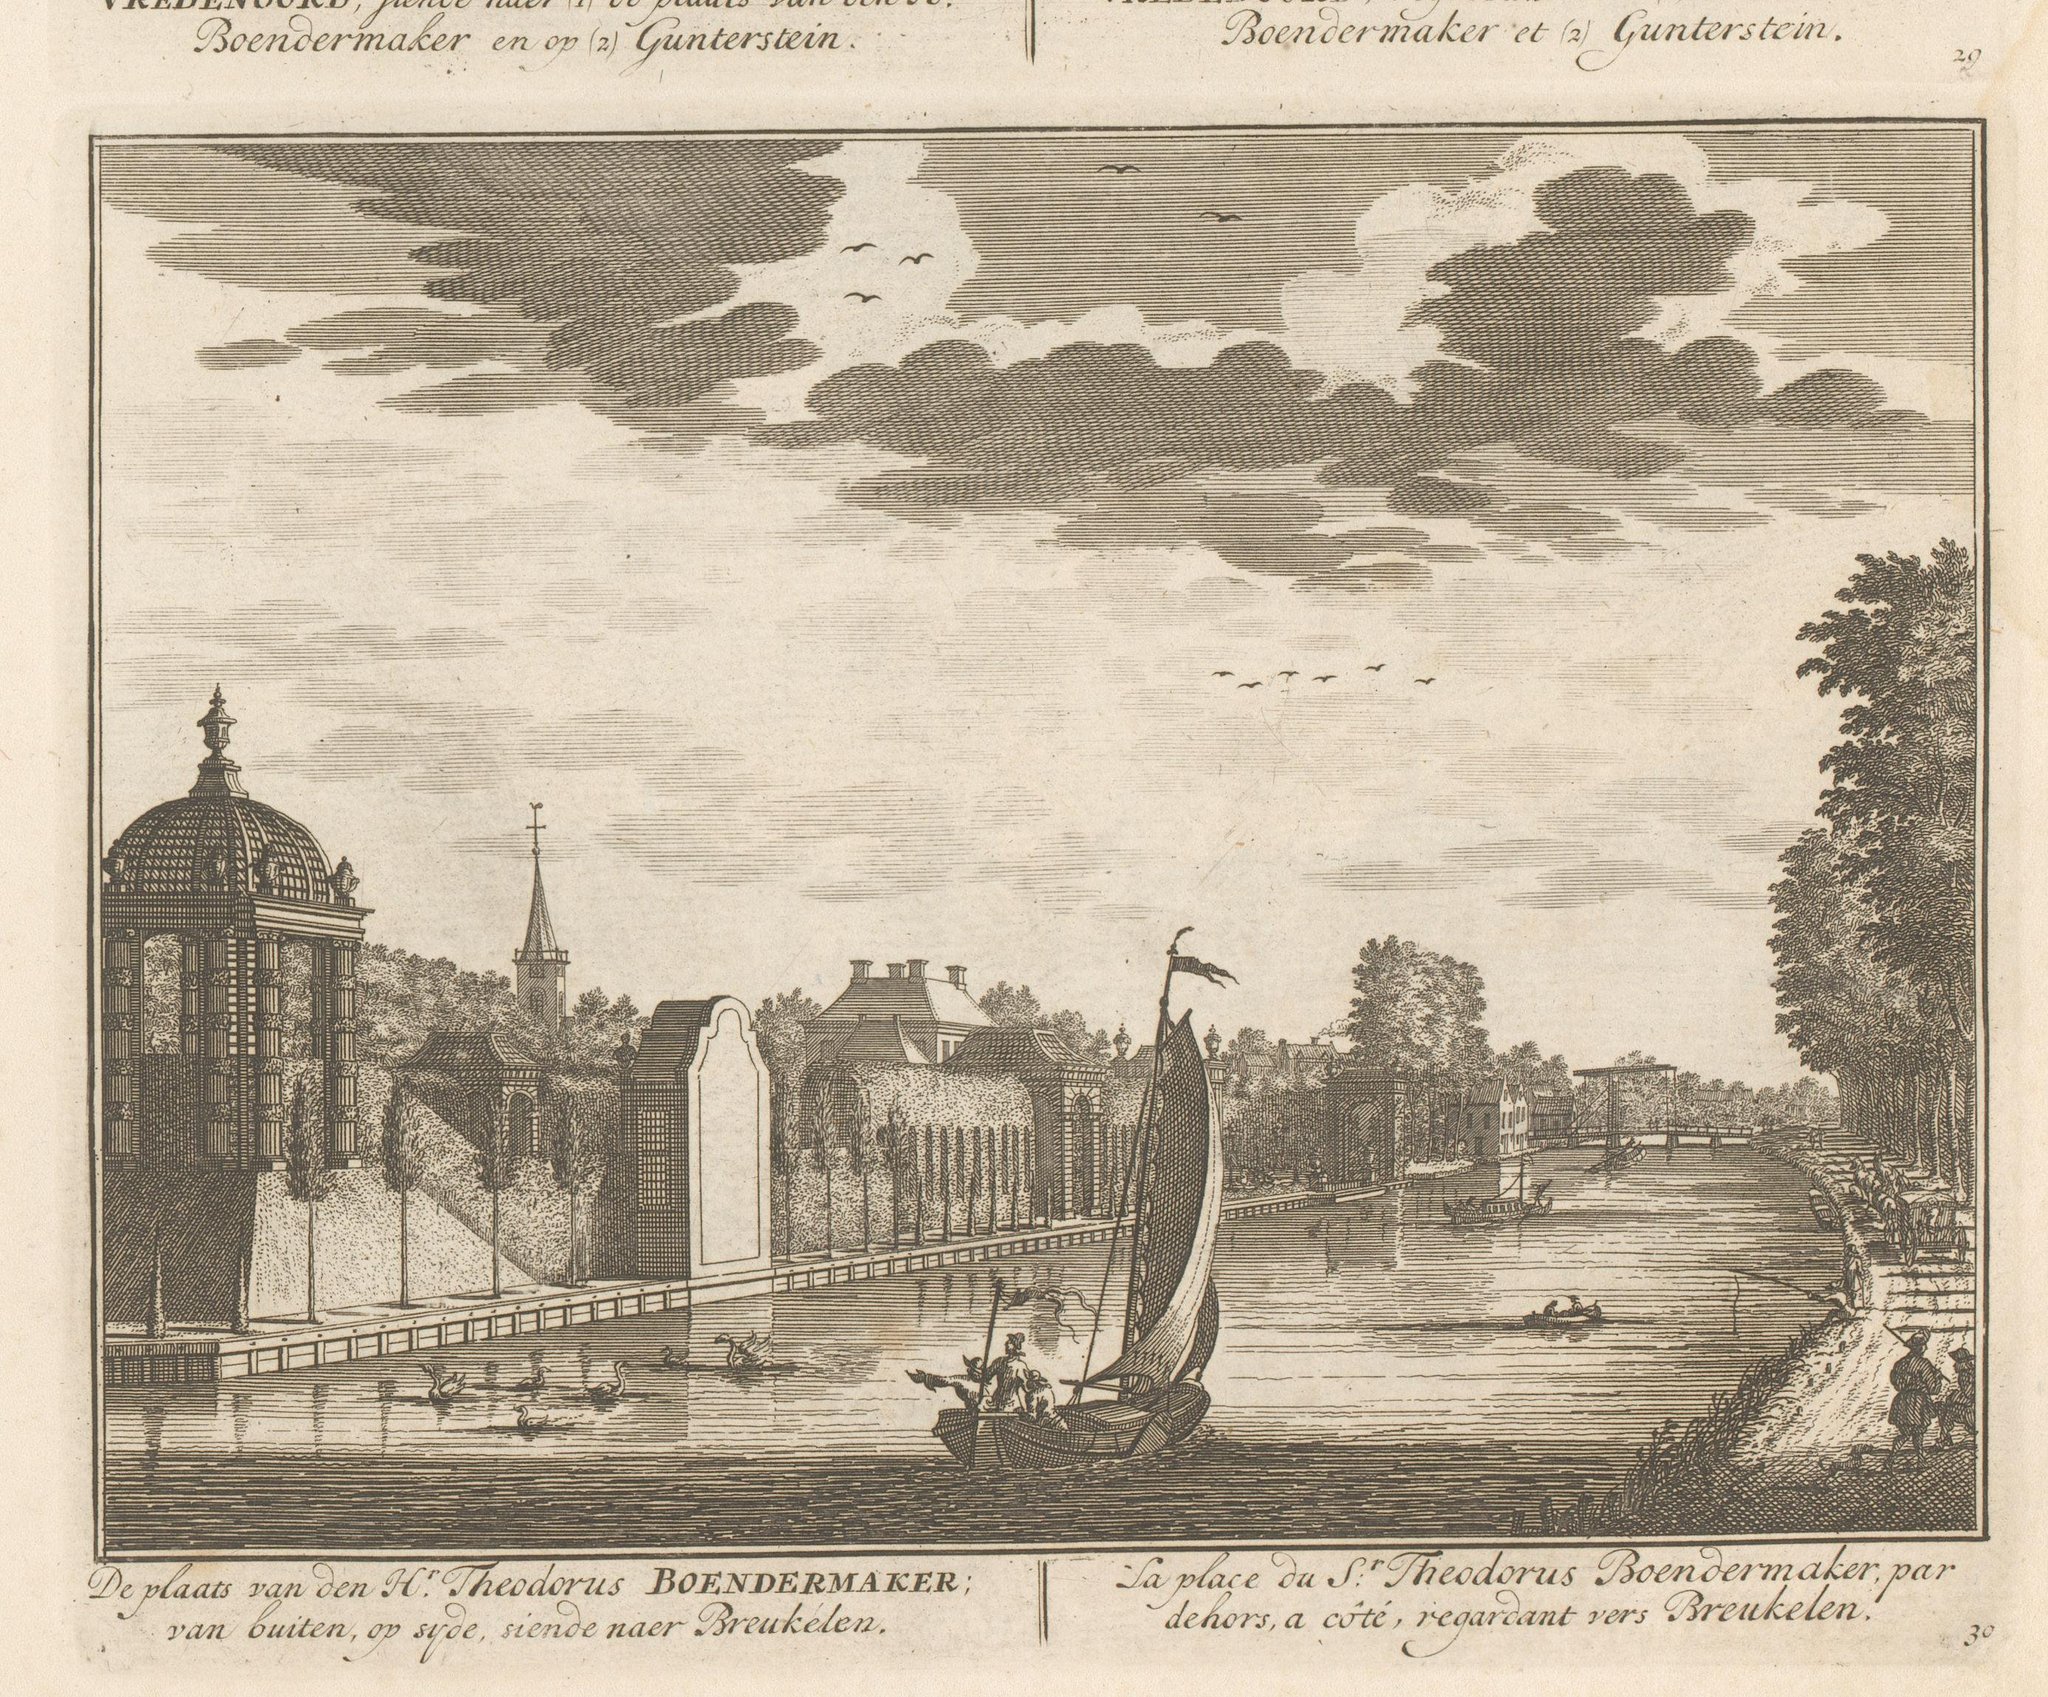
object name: book illustration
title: De plaats van den H. Theodorus Boendermaker: van buiten op syde , siende naer Breukelen / La place du S: Theodorus Boendermaker par dehors, a côté, regardant vers Breukelen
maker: daniël stopendaal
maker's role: print maker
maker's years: 1672-1726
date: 1790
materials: paper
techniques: engraving, etching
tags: sailing-ship, sailing-boat, river (+ landscape with figures, staffage), country-house, vecht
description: Prent gebruikt in: Leth, Andries de. De zegepraalende Vecht, vertoonende verscheidene gesichten van lustplaatsen, heeren huysen en dorpen, beginnende van Uitrecht en met Muyden besluytende (...). Amsterdam: Weduwe Nicolaus Visscher, 1719. Prent ook gebruikt in: Brouërius van Nidek, Matthaeus. De Vechtstroom, van Utrecht tot Muiden (...). Amsterdam: H. Gartman, W. Vermandel en J.W. Smit, 1790.